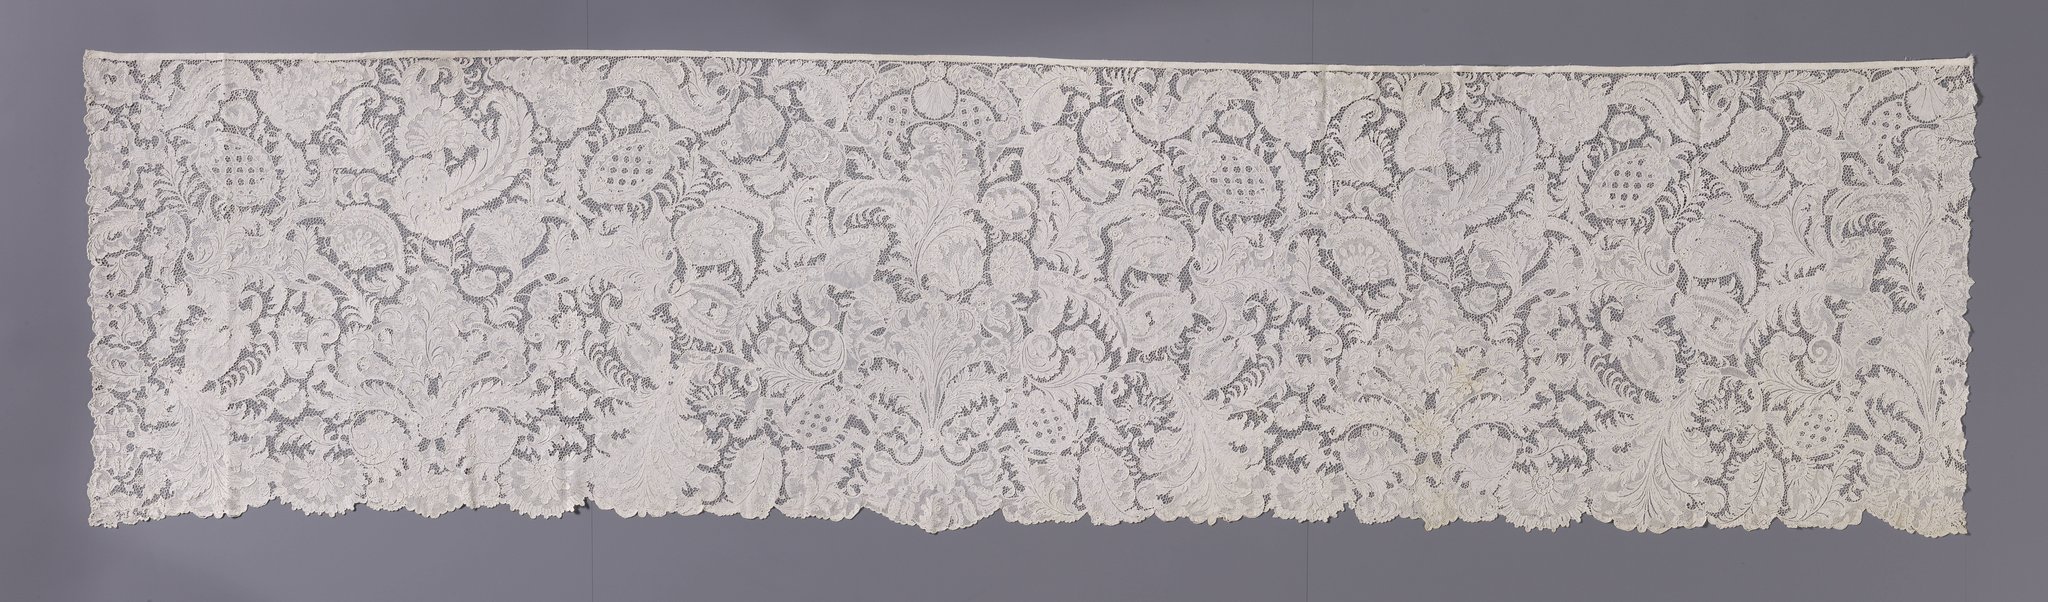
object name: strip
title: Albestrook van naaldkant met granaatappels en veren en centraal een sint-jacobsschelp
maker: Anonymous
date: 1720-1725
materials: linen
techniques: mesh ground, needle lace, sedan lace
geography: sedan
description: Albestrook van naturelkleurige naaldkant: Sedan-kant. Patroon met grote en rijk versierde motieven in de vorm van onder andere granaatappels en veren met een zeshoekige gepicoteerde maasgrond. Het patroon is symmetrisch ten opzichte van de sint-jacobsschelp middenbovenin de albe. De rijke versieringen in de motieven zijn gemaakt met allerlei verschillende patronen door middel van uitsparingen in het volwerk. Hier en daar gefestonneerde reliëfcontourlijnen. De bovenrand is afgezet met een rand kloskant en verstevigd met een geweven bandje. De schulpenrand aan de onderzijde komt voort uit het patroon. Tevens schulpen langs de linkerzijde, de rechterzijde is met een golvende lijn afgeknipt.